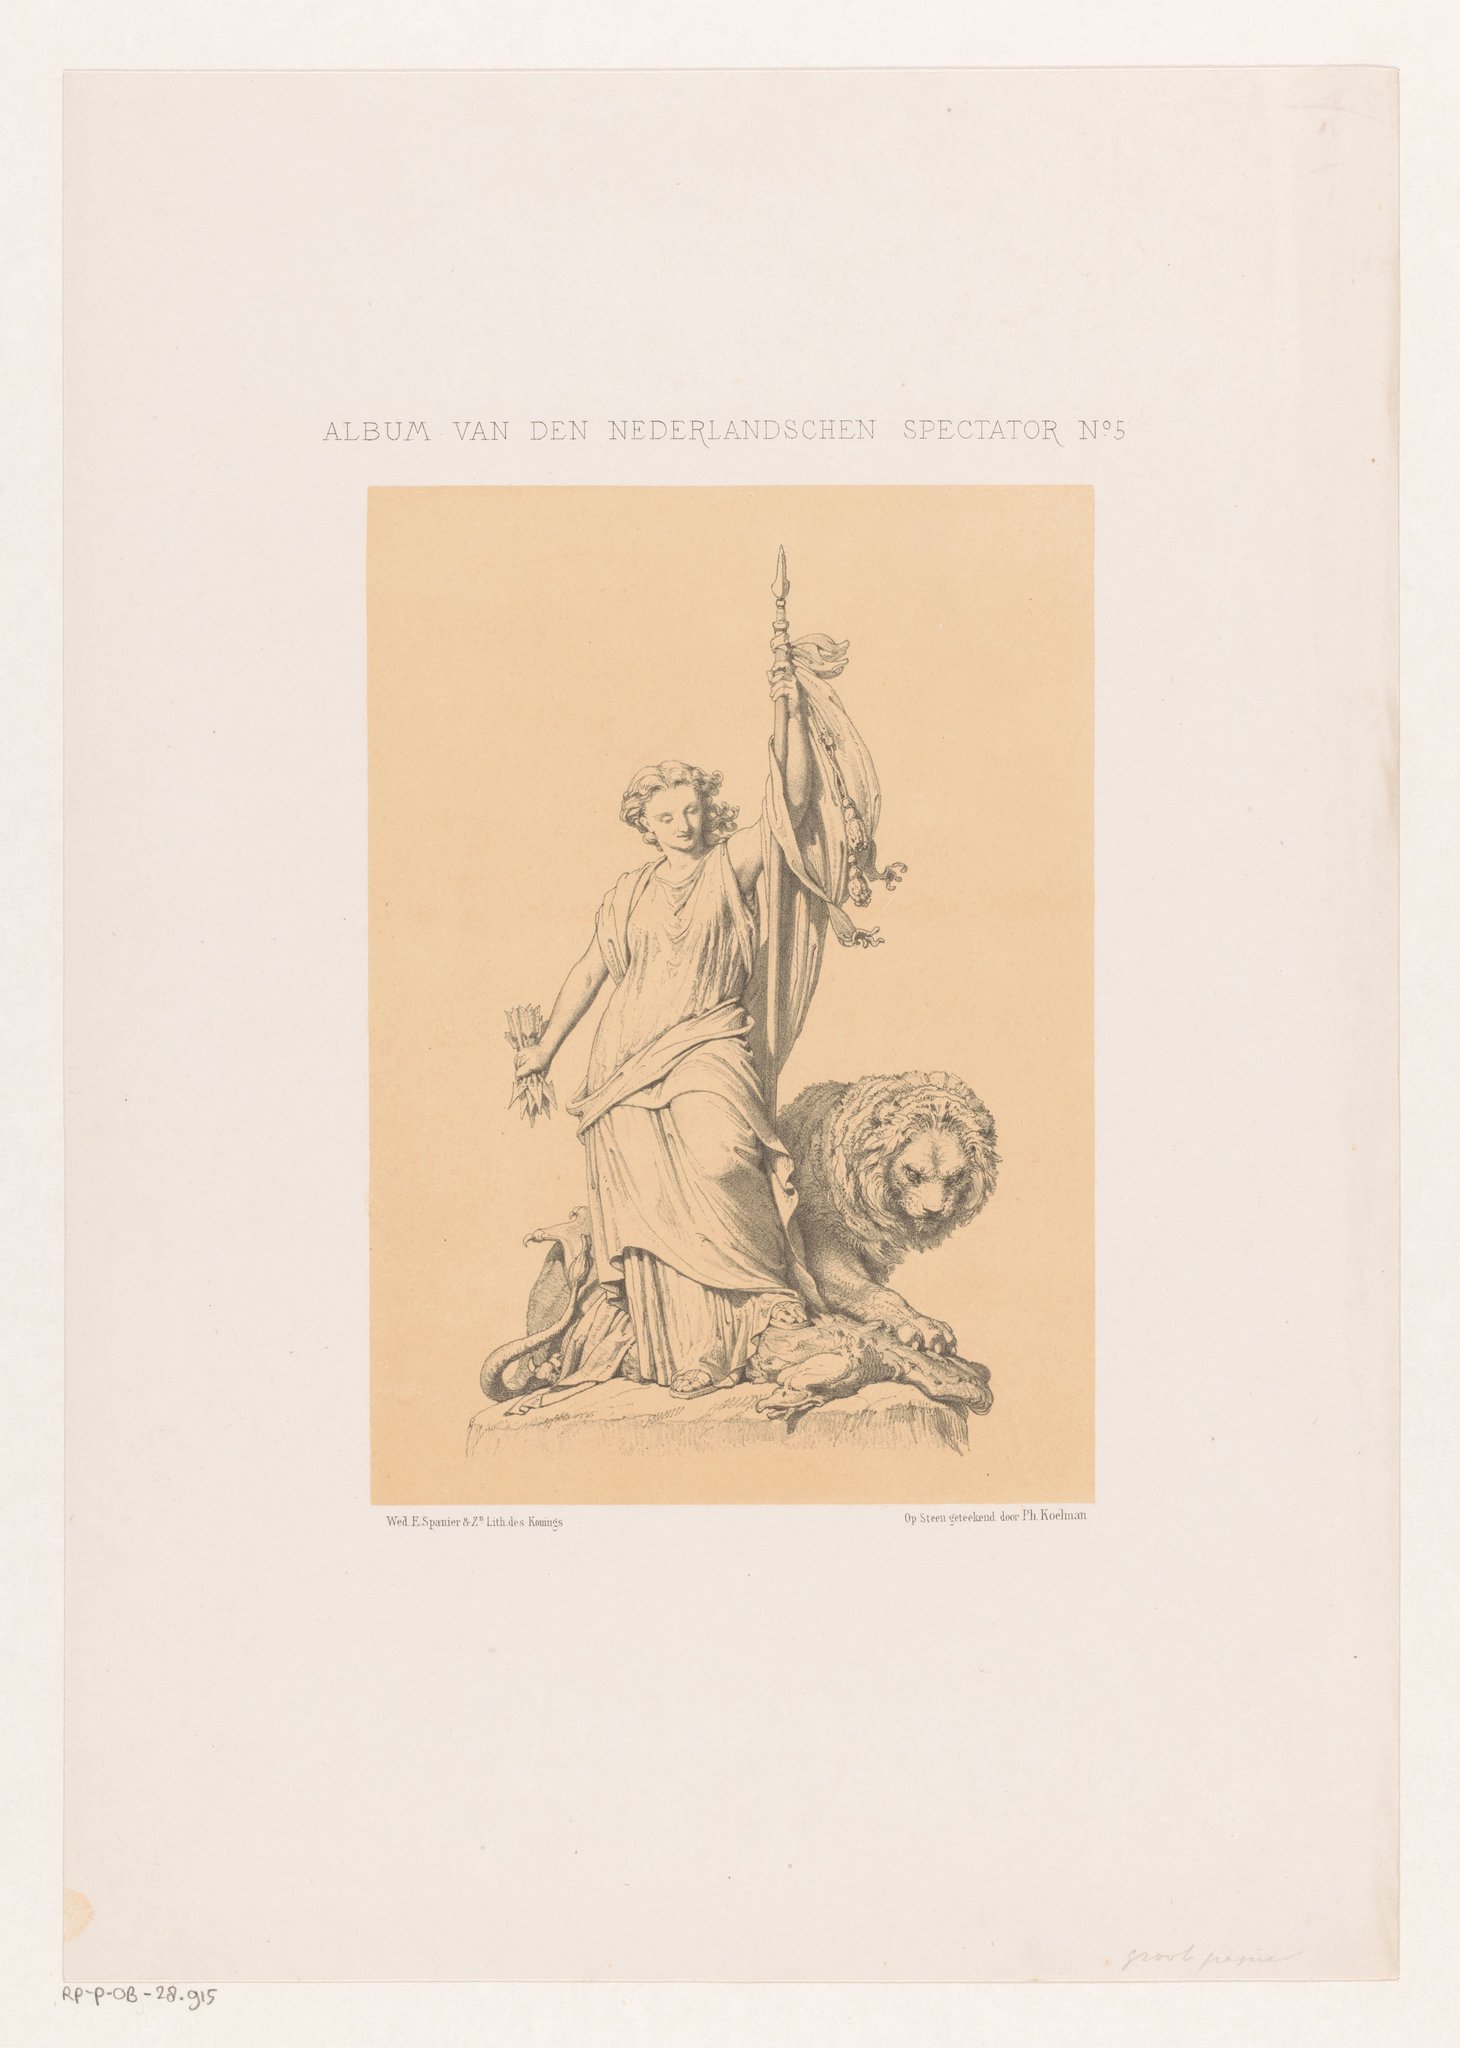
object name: print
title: Album van den nederlandschen Spectator No 5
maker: johan philip koelman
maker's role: draughtsman, painter, print maker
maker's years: 1818-1893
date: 1863-1869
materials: paper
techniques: tone lithography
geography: the hague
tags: personifications of countries, nations, states, districts, etc., beasts of prey, predatory animals: lion, the hague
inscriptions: collector's mark: Lugt 2228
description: De opdracht tot het bouwen van een monument was een initiatief van de 'Vereeniging van en voor Industriëlen' toen het Koninkrijk der Nederlanden vijftig jaar bestond. Samen met prins Frederik werd een zogenaamde Hoofdcommissie gevormd om een nationaal monument te realiseren. Er volgden 28 inzendingen. Tussen 1863 en 1869 woedde er een polemiek tussen de kampen achter de twee finalisten, een strijd tussen liberalen, die de gezamenlijke inzending van W.C. van der Waayen Pieterszen en J. Ph. Koelman steunden, en de katholieken, die stonden achter het ontwerp P.J.H. Cuypers. Deze prent werd uitgegeven in De Nederlandsche Spectator. Het hier afgebeelde ontwerp komt niet helemaal overeen met het uiteindelijke monument. Zie: Schulten, K. 'Plein 1813. Het nationaal monument in Den Haag.' Den Haag: Nieuwe Haagsche Uitgeverij, 2013.